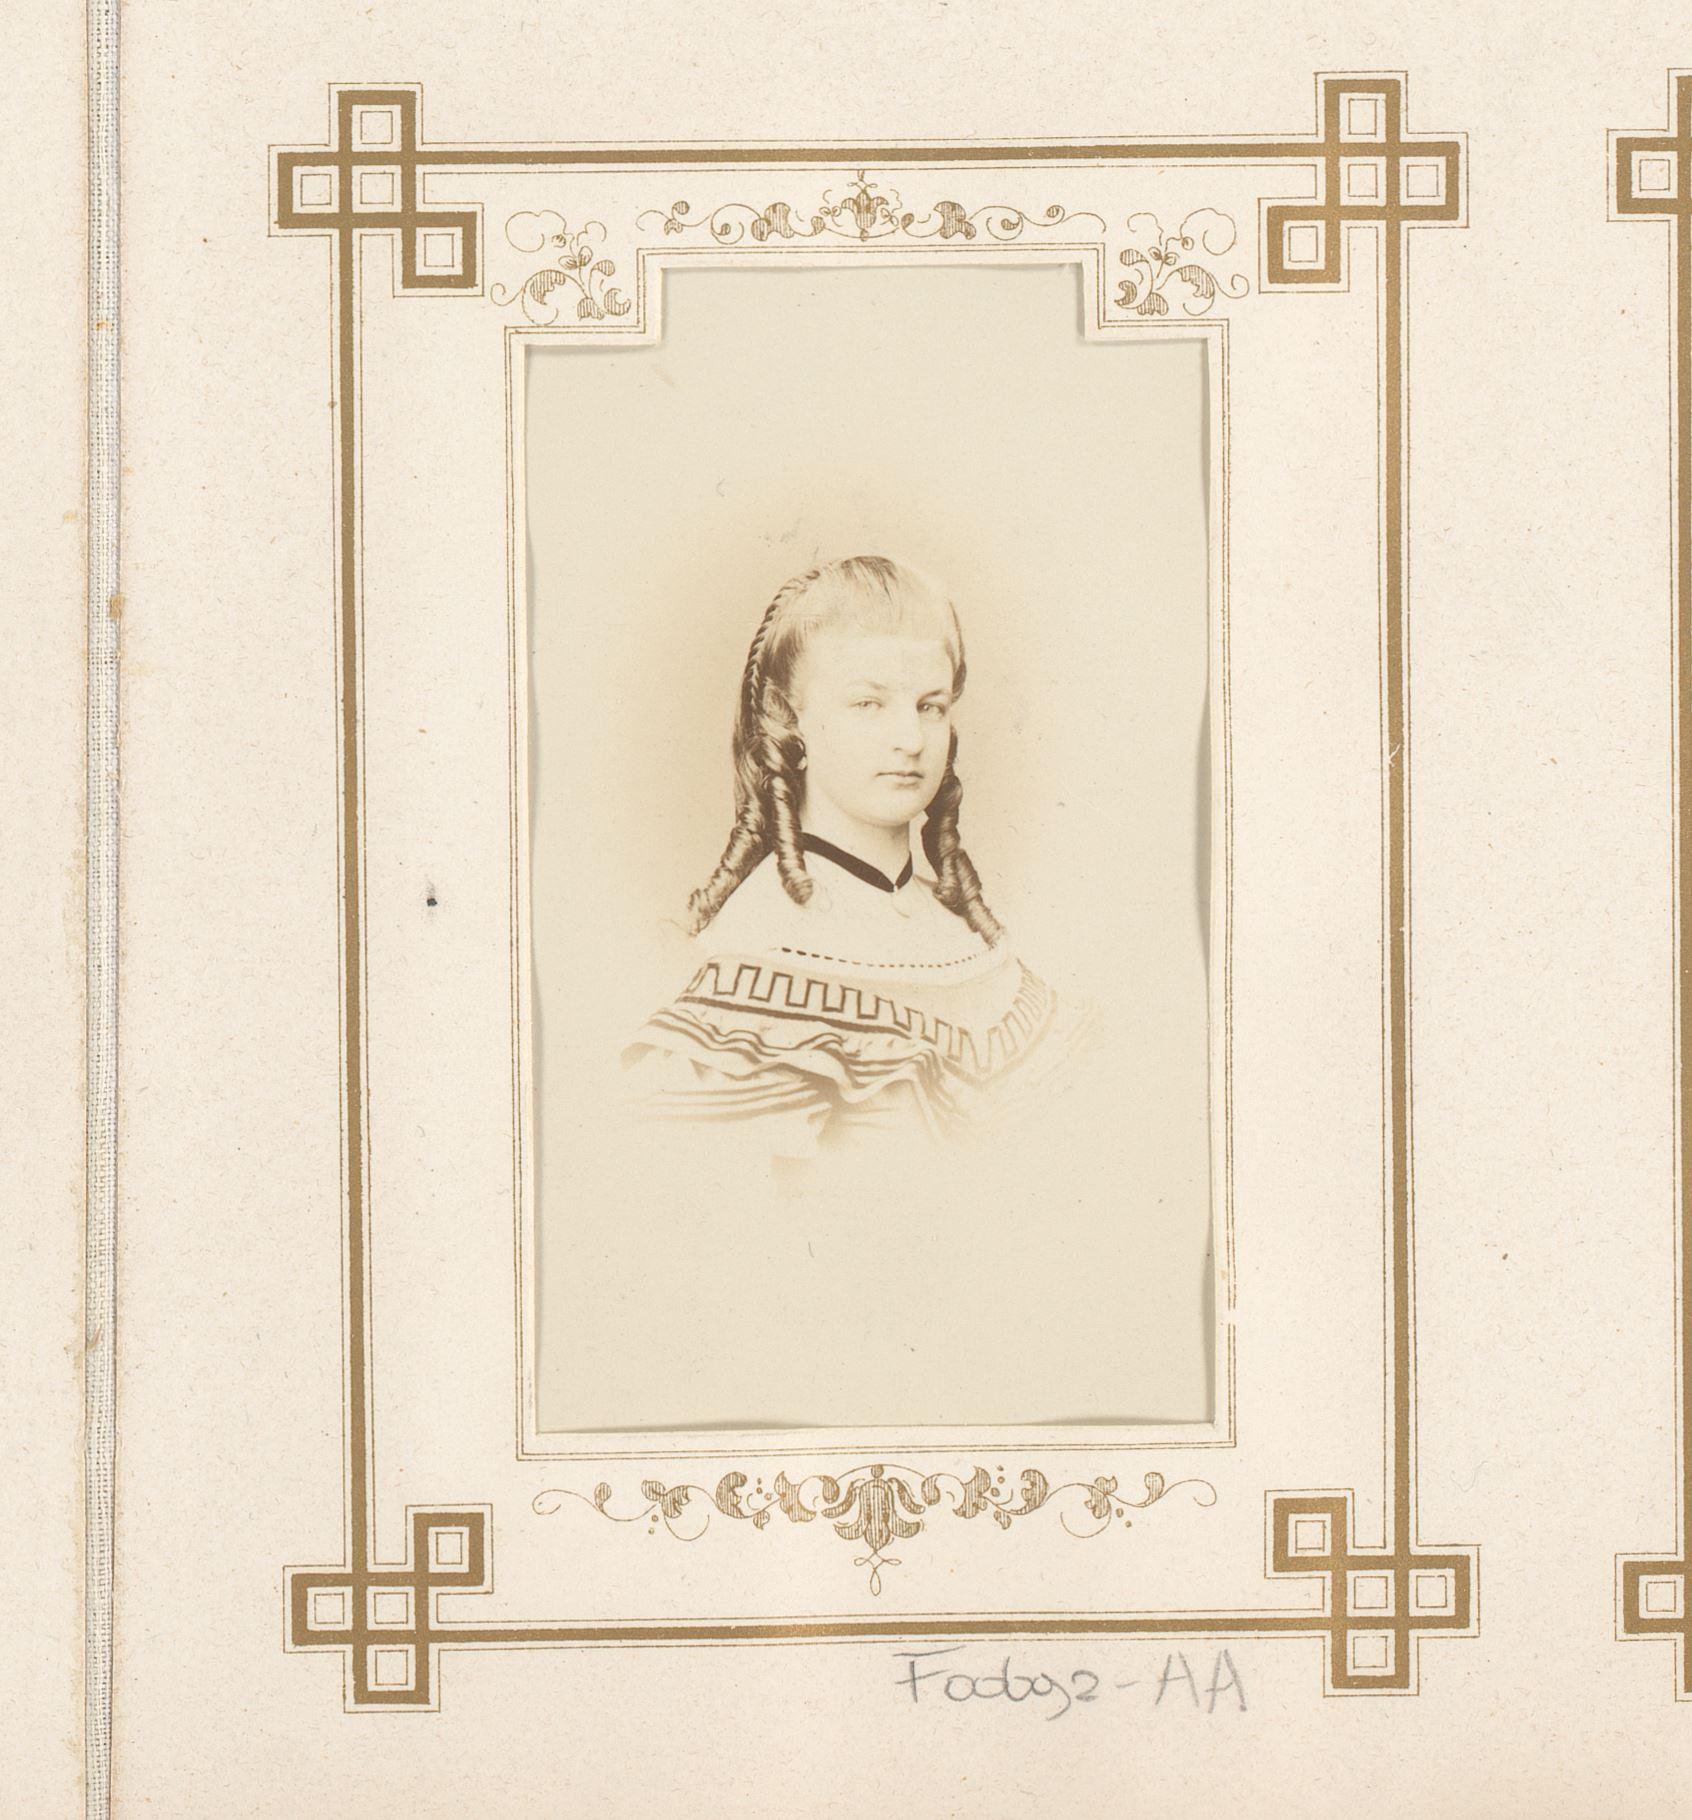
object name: album leaf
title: Portret van een jonge vrouw met pijpenkrullen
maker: ludwig angerer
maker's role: fotograaf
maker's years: 1827-1879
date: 1865-1875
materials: cardboard, photographic support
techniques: albumen print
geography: vienna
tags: adolescent, young woman, maiden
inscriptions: inscription: ‘L. Angerer/ K.K. Hof-Photograph in Wien’